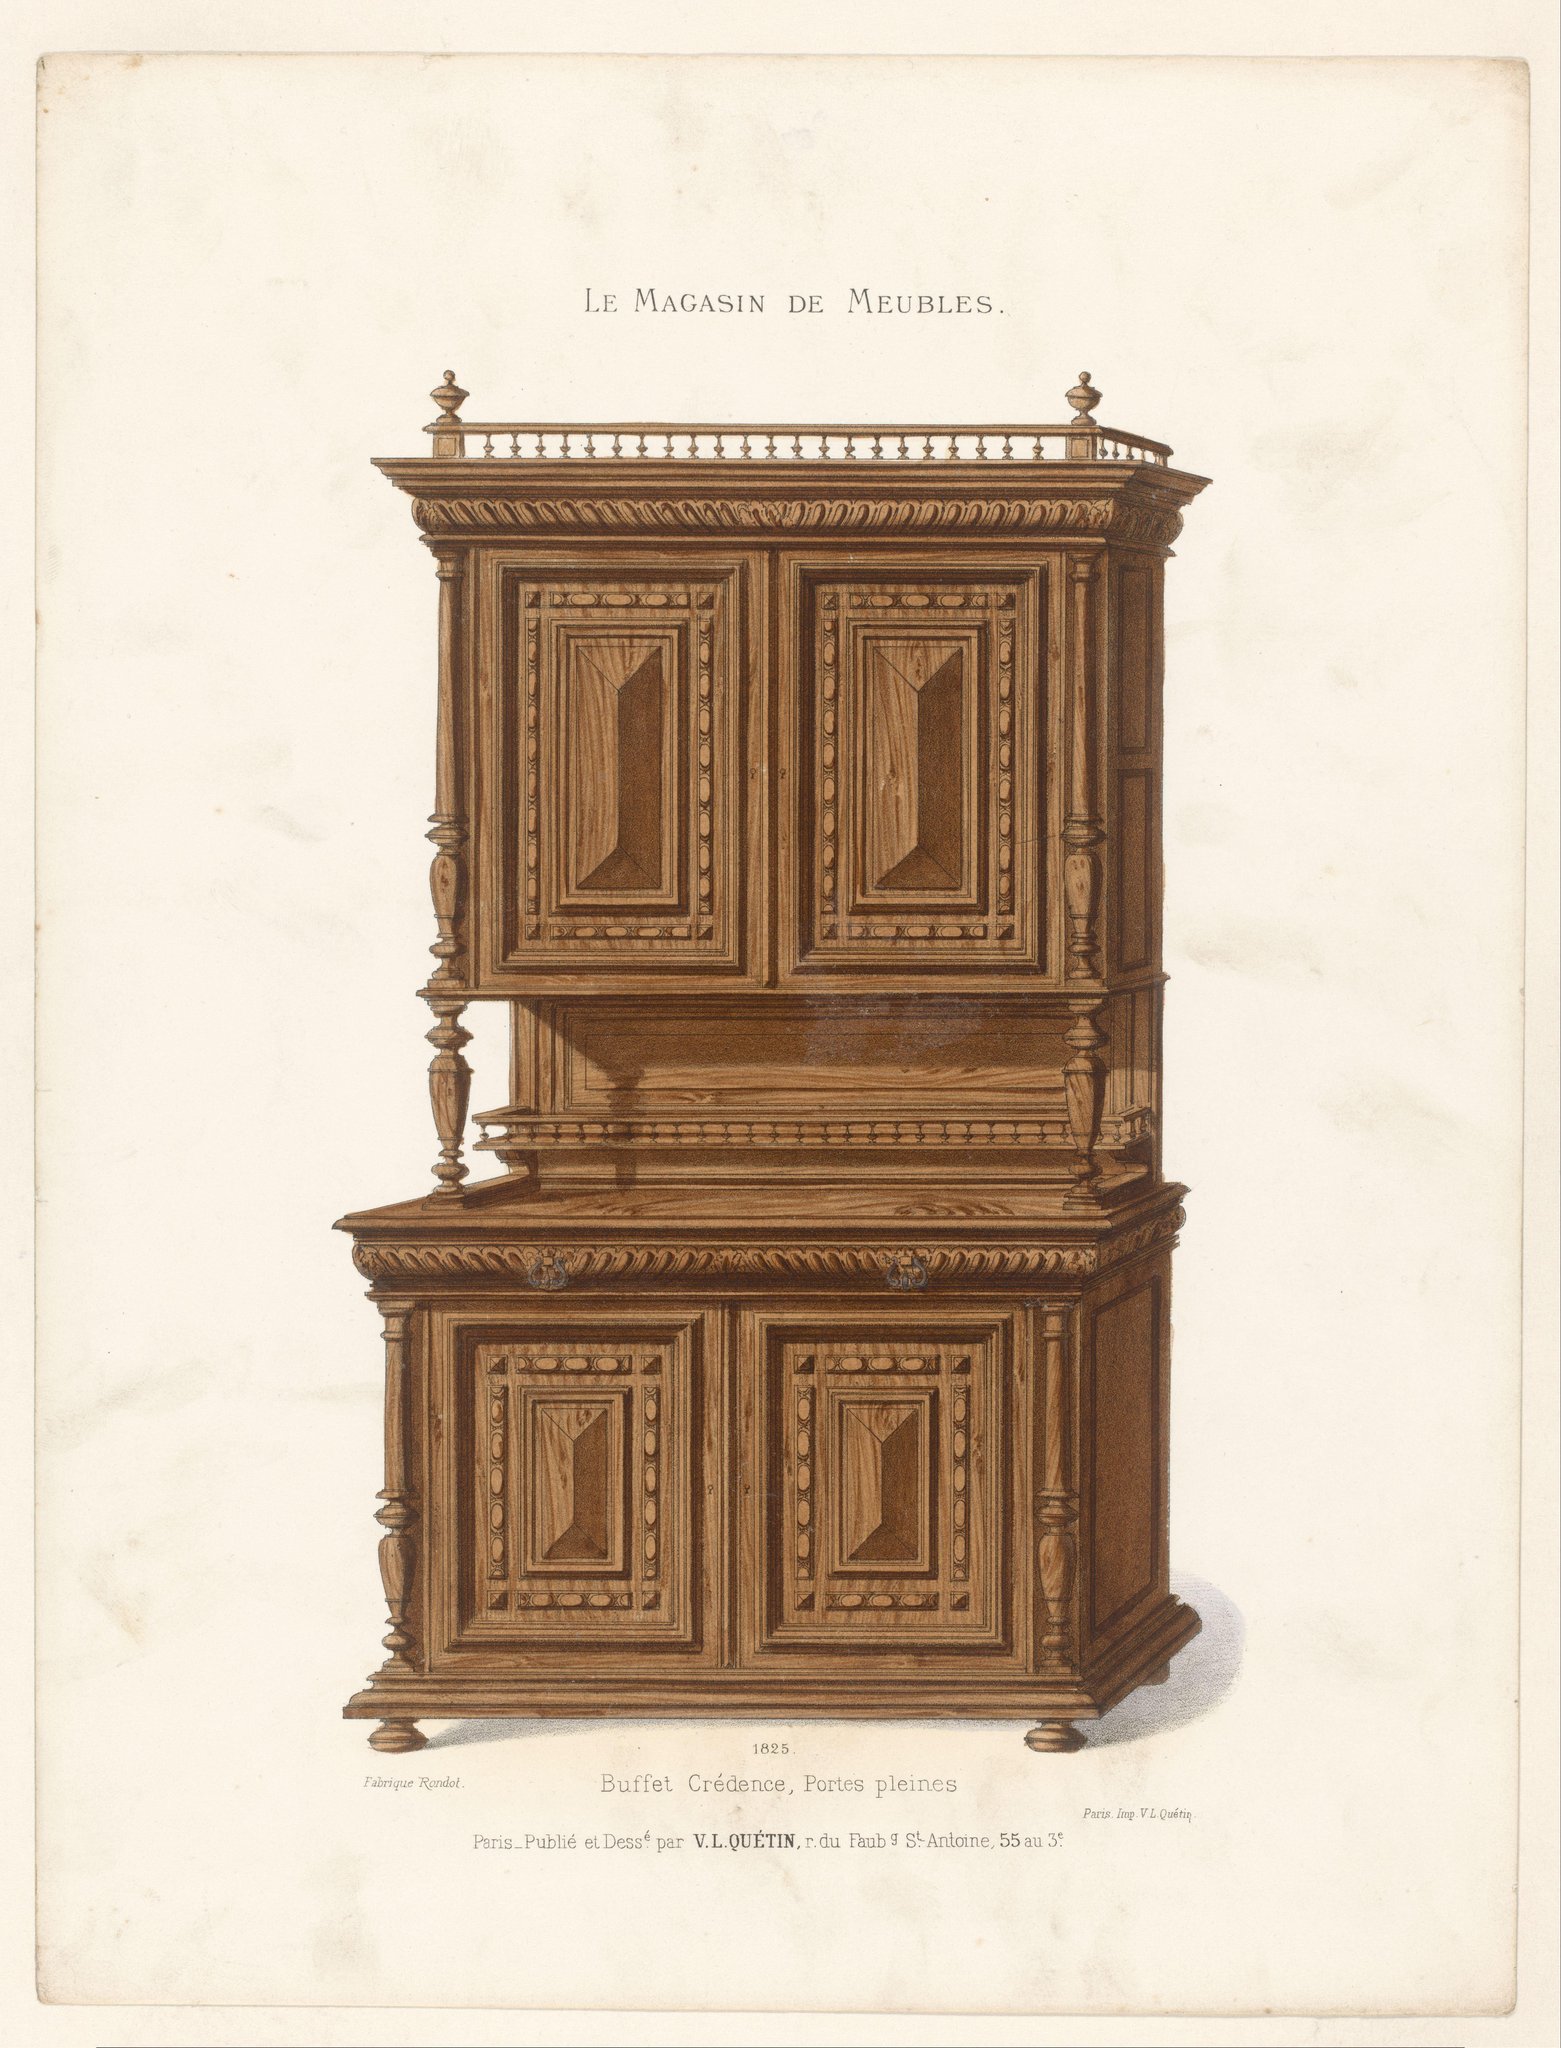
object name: print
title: Buffet Crédence, Portes pleines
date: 1878-1904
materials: paper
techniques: hand coloring, lithograph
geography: paris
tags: furniture for storage